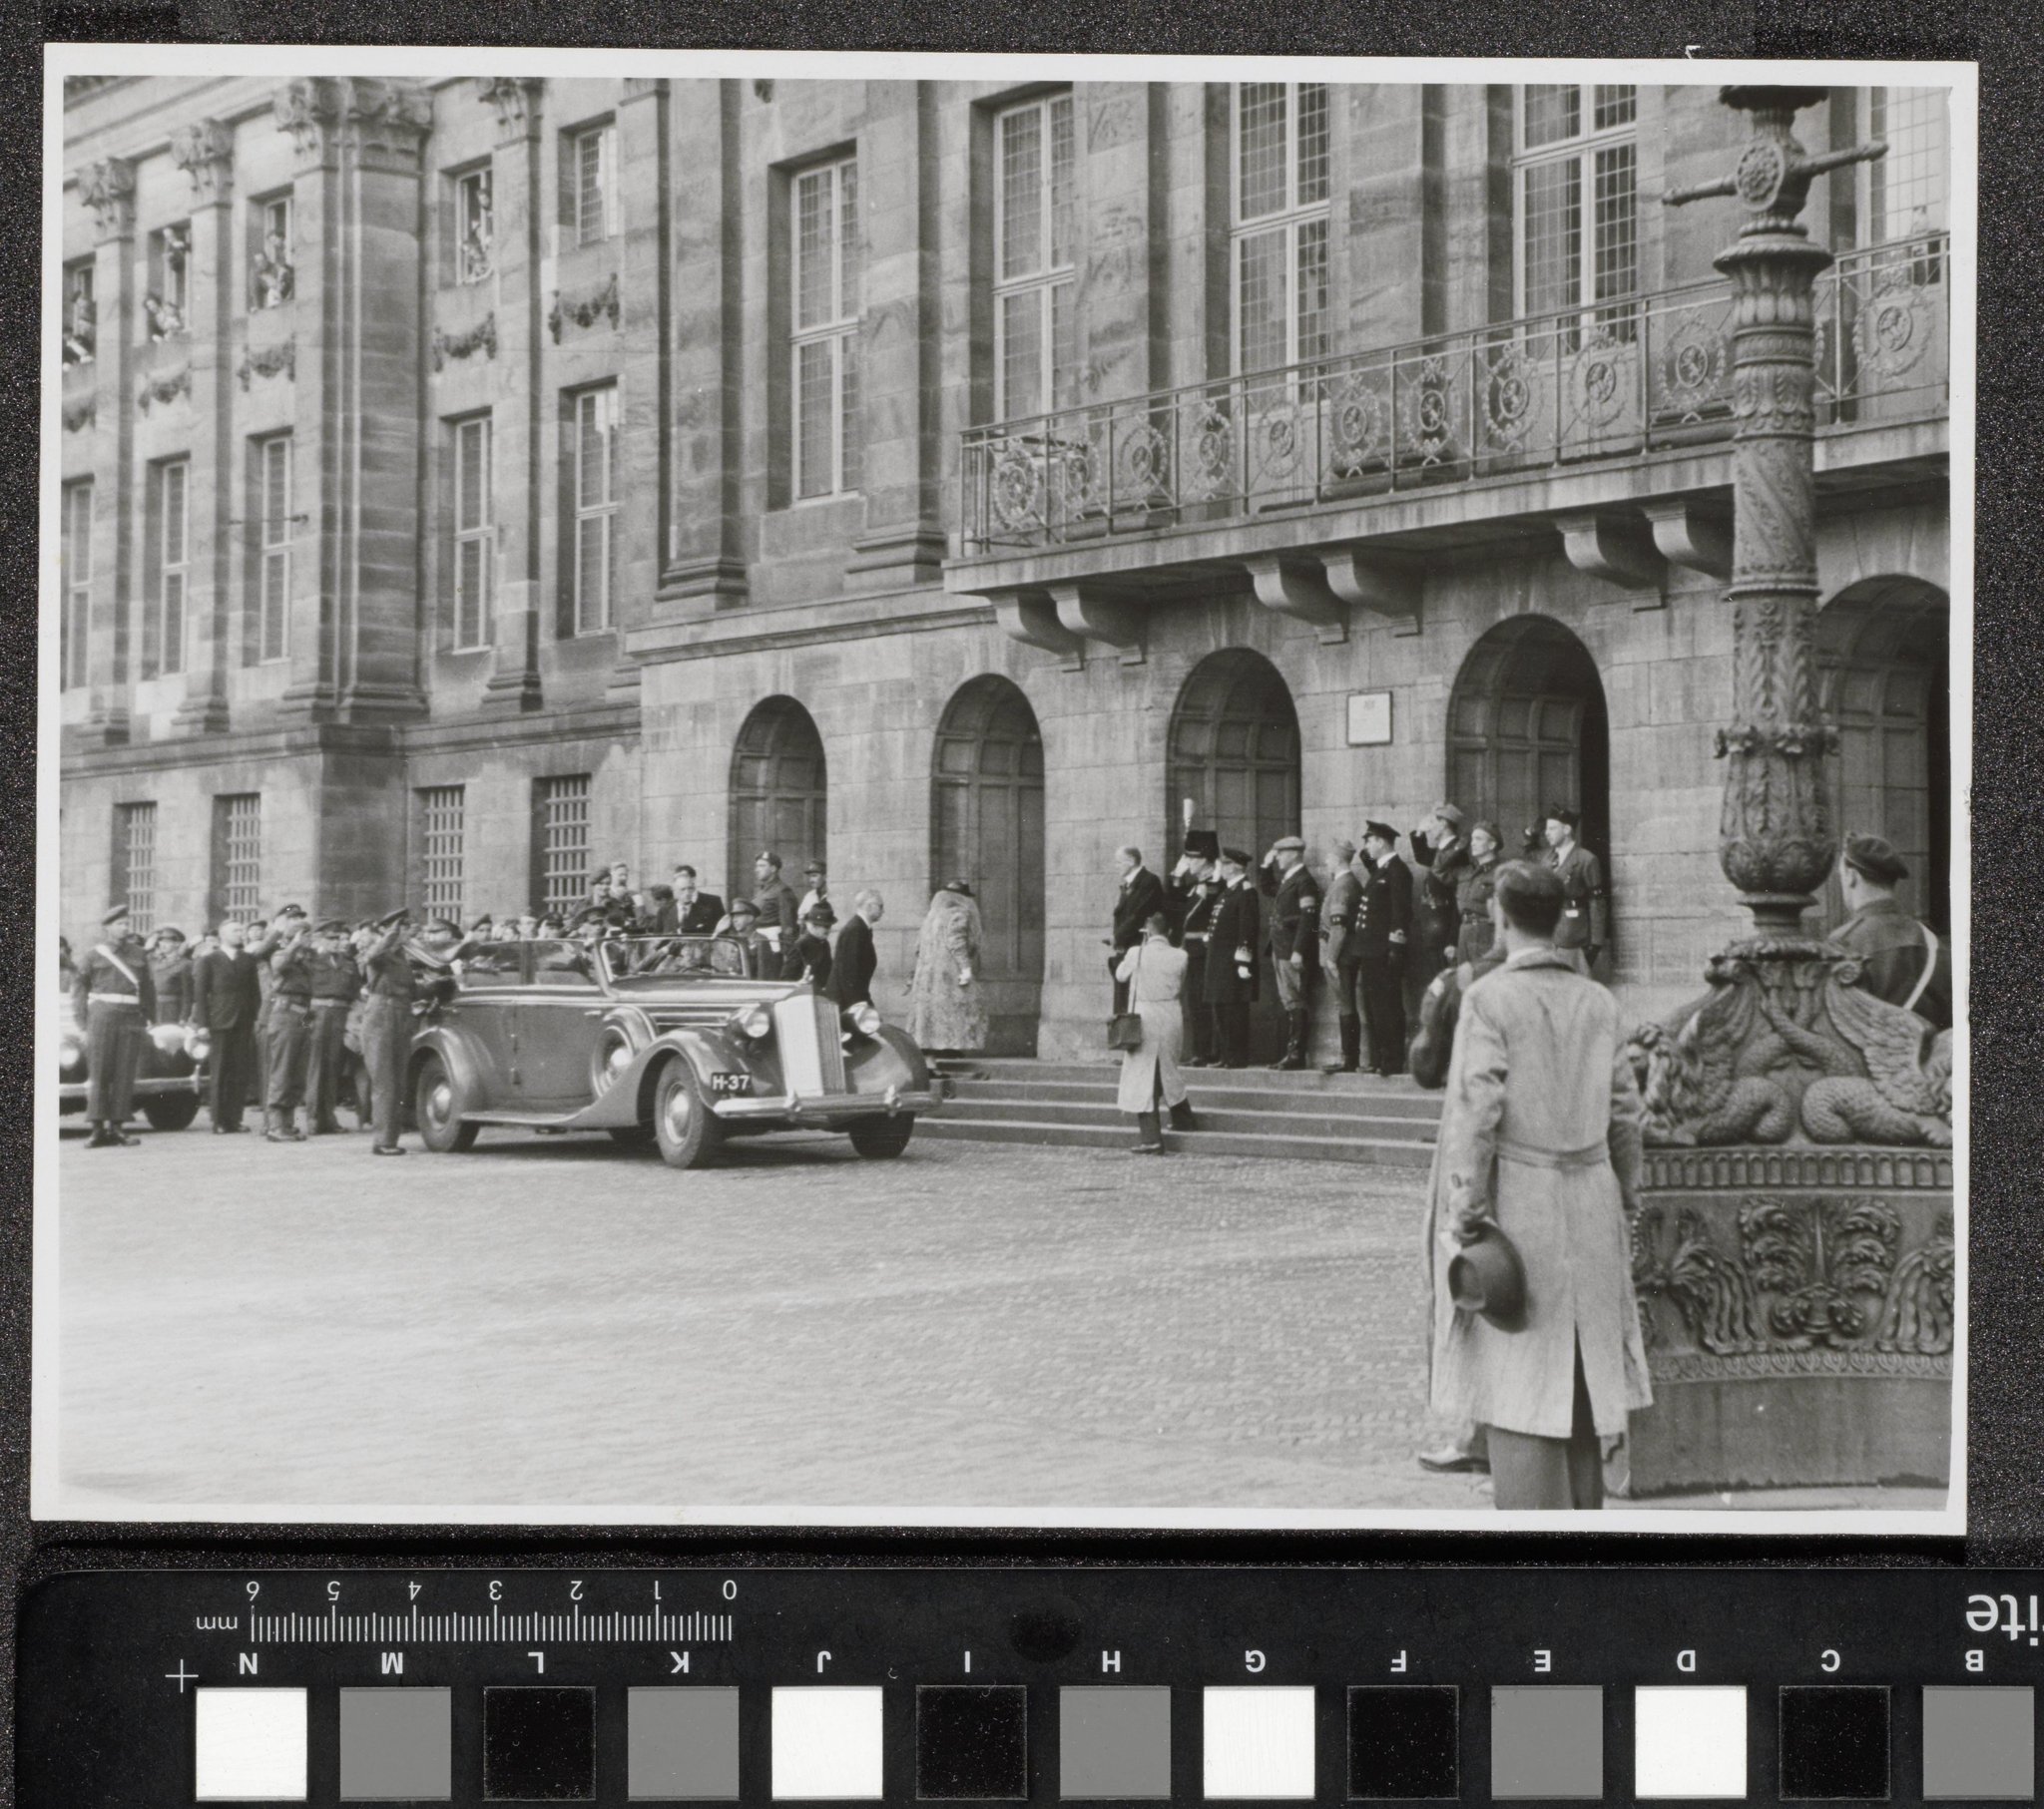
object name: photograph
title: Koningin Wilhelmina betreedt het Koninklijk Paleis te Amsterdam tijdens haar officiële rentrée in Amsterdam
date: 1945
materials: photographic support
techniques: gelatin silver print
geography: dam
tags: wilhelmina of the netherlands, queen, empress, etc. (wife of a ruler), palace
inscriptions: name: ‘Copyright Nederlandsch Christelijk Persfotobureau’, address: ‘Olympiaplein 170 Amsterdam-Z.’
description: Onderdeel van Fotoalbum gemaakt door Eva Pennink met opnames van de prinsessen Beatrix, Irene, Margriet en Marijke uit de periode 1948-1951.